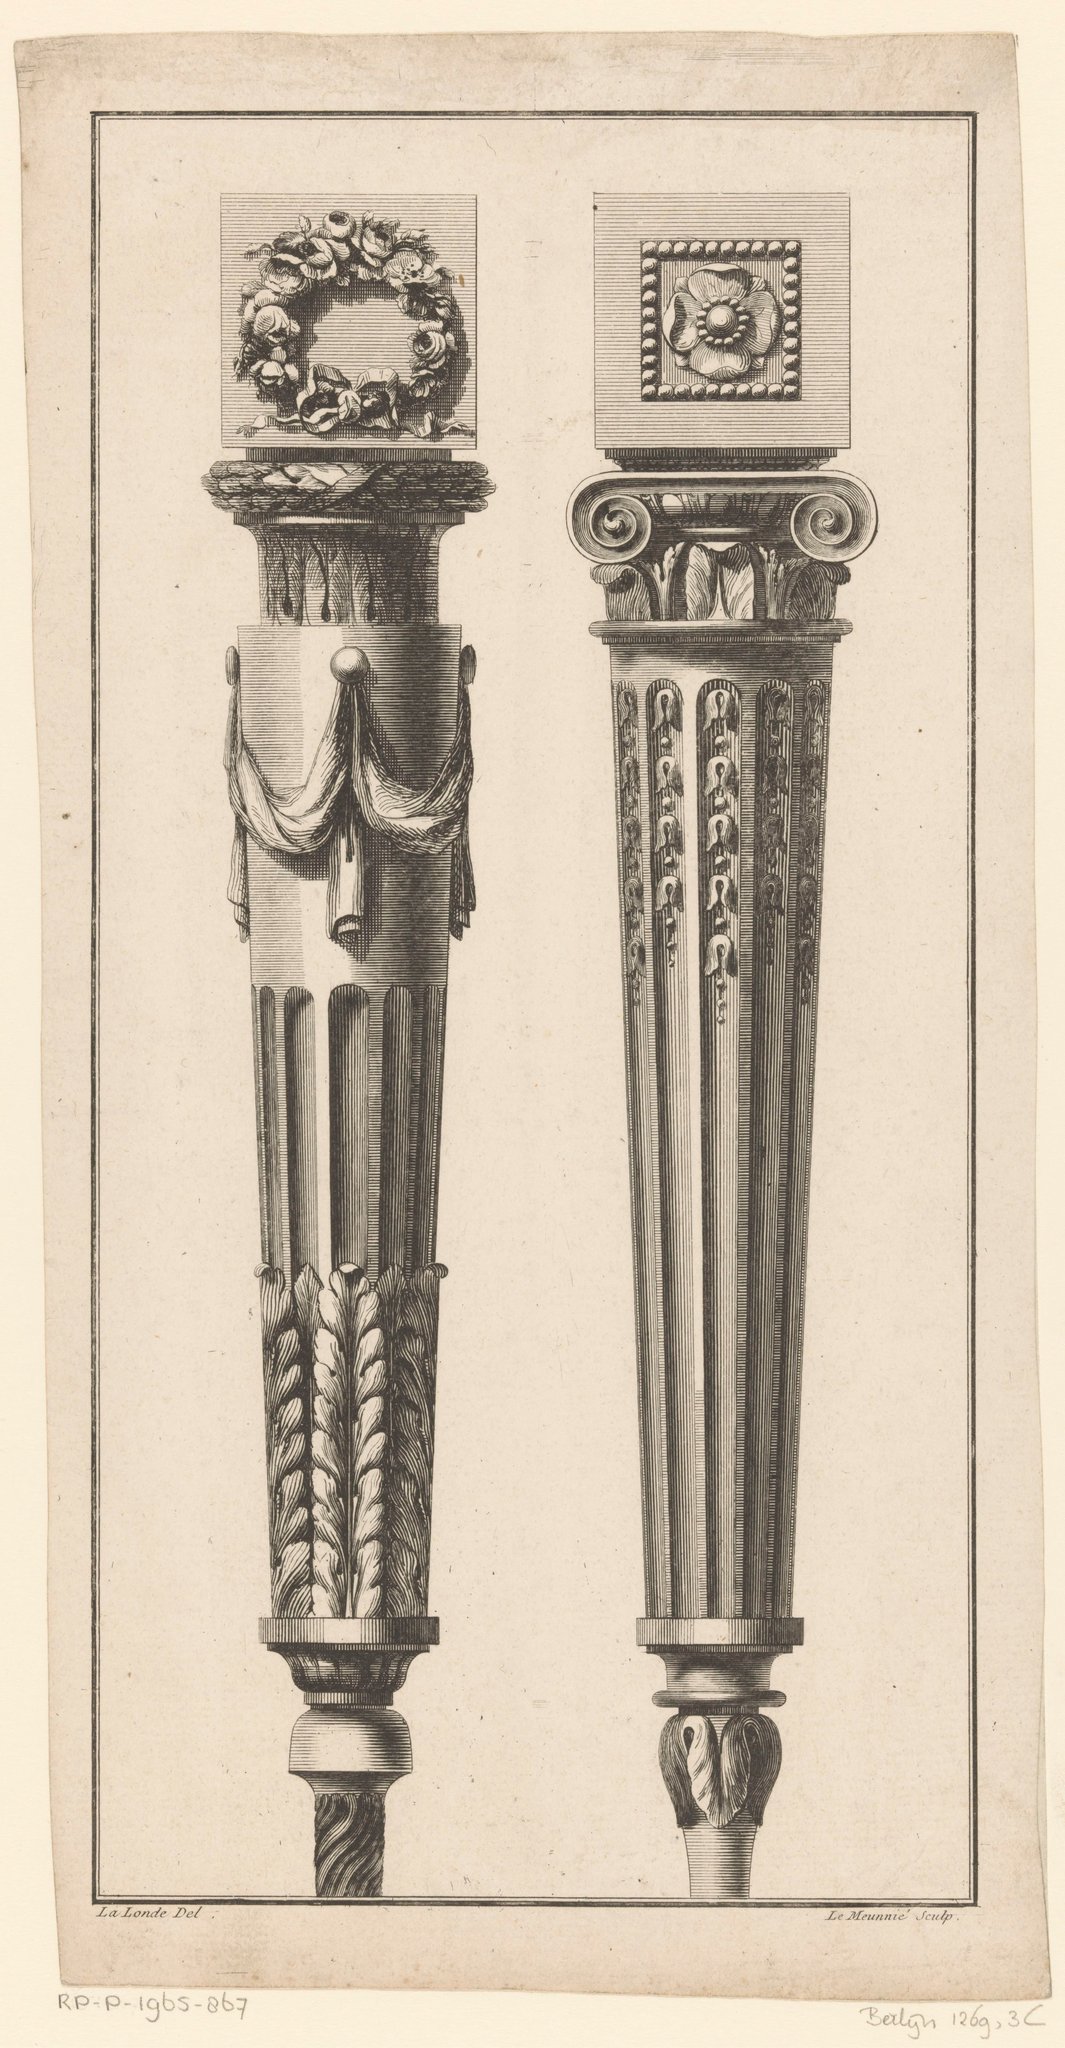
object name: ornament print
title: Twee meubelpoten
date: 1784-1785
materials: paper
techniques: engraving, etching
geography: paris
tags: furniture and household effects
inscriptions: collector's mark: Lugt 2760, collector's mark: Lugt 2228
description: Twee geornamenteerde meubelpoten, links met krans en draperieën, rechts met bloemmotief en voluten.